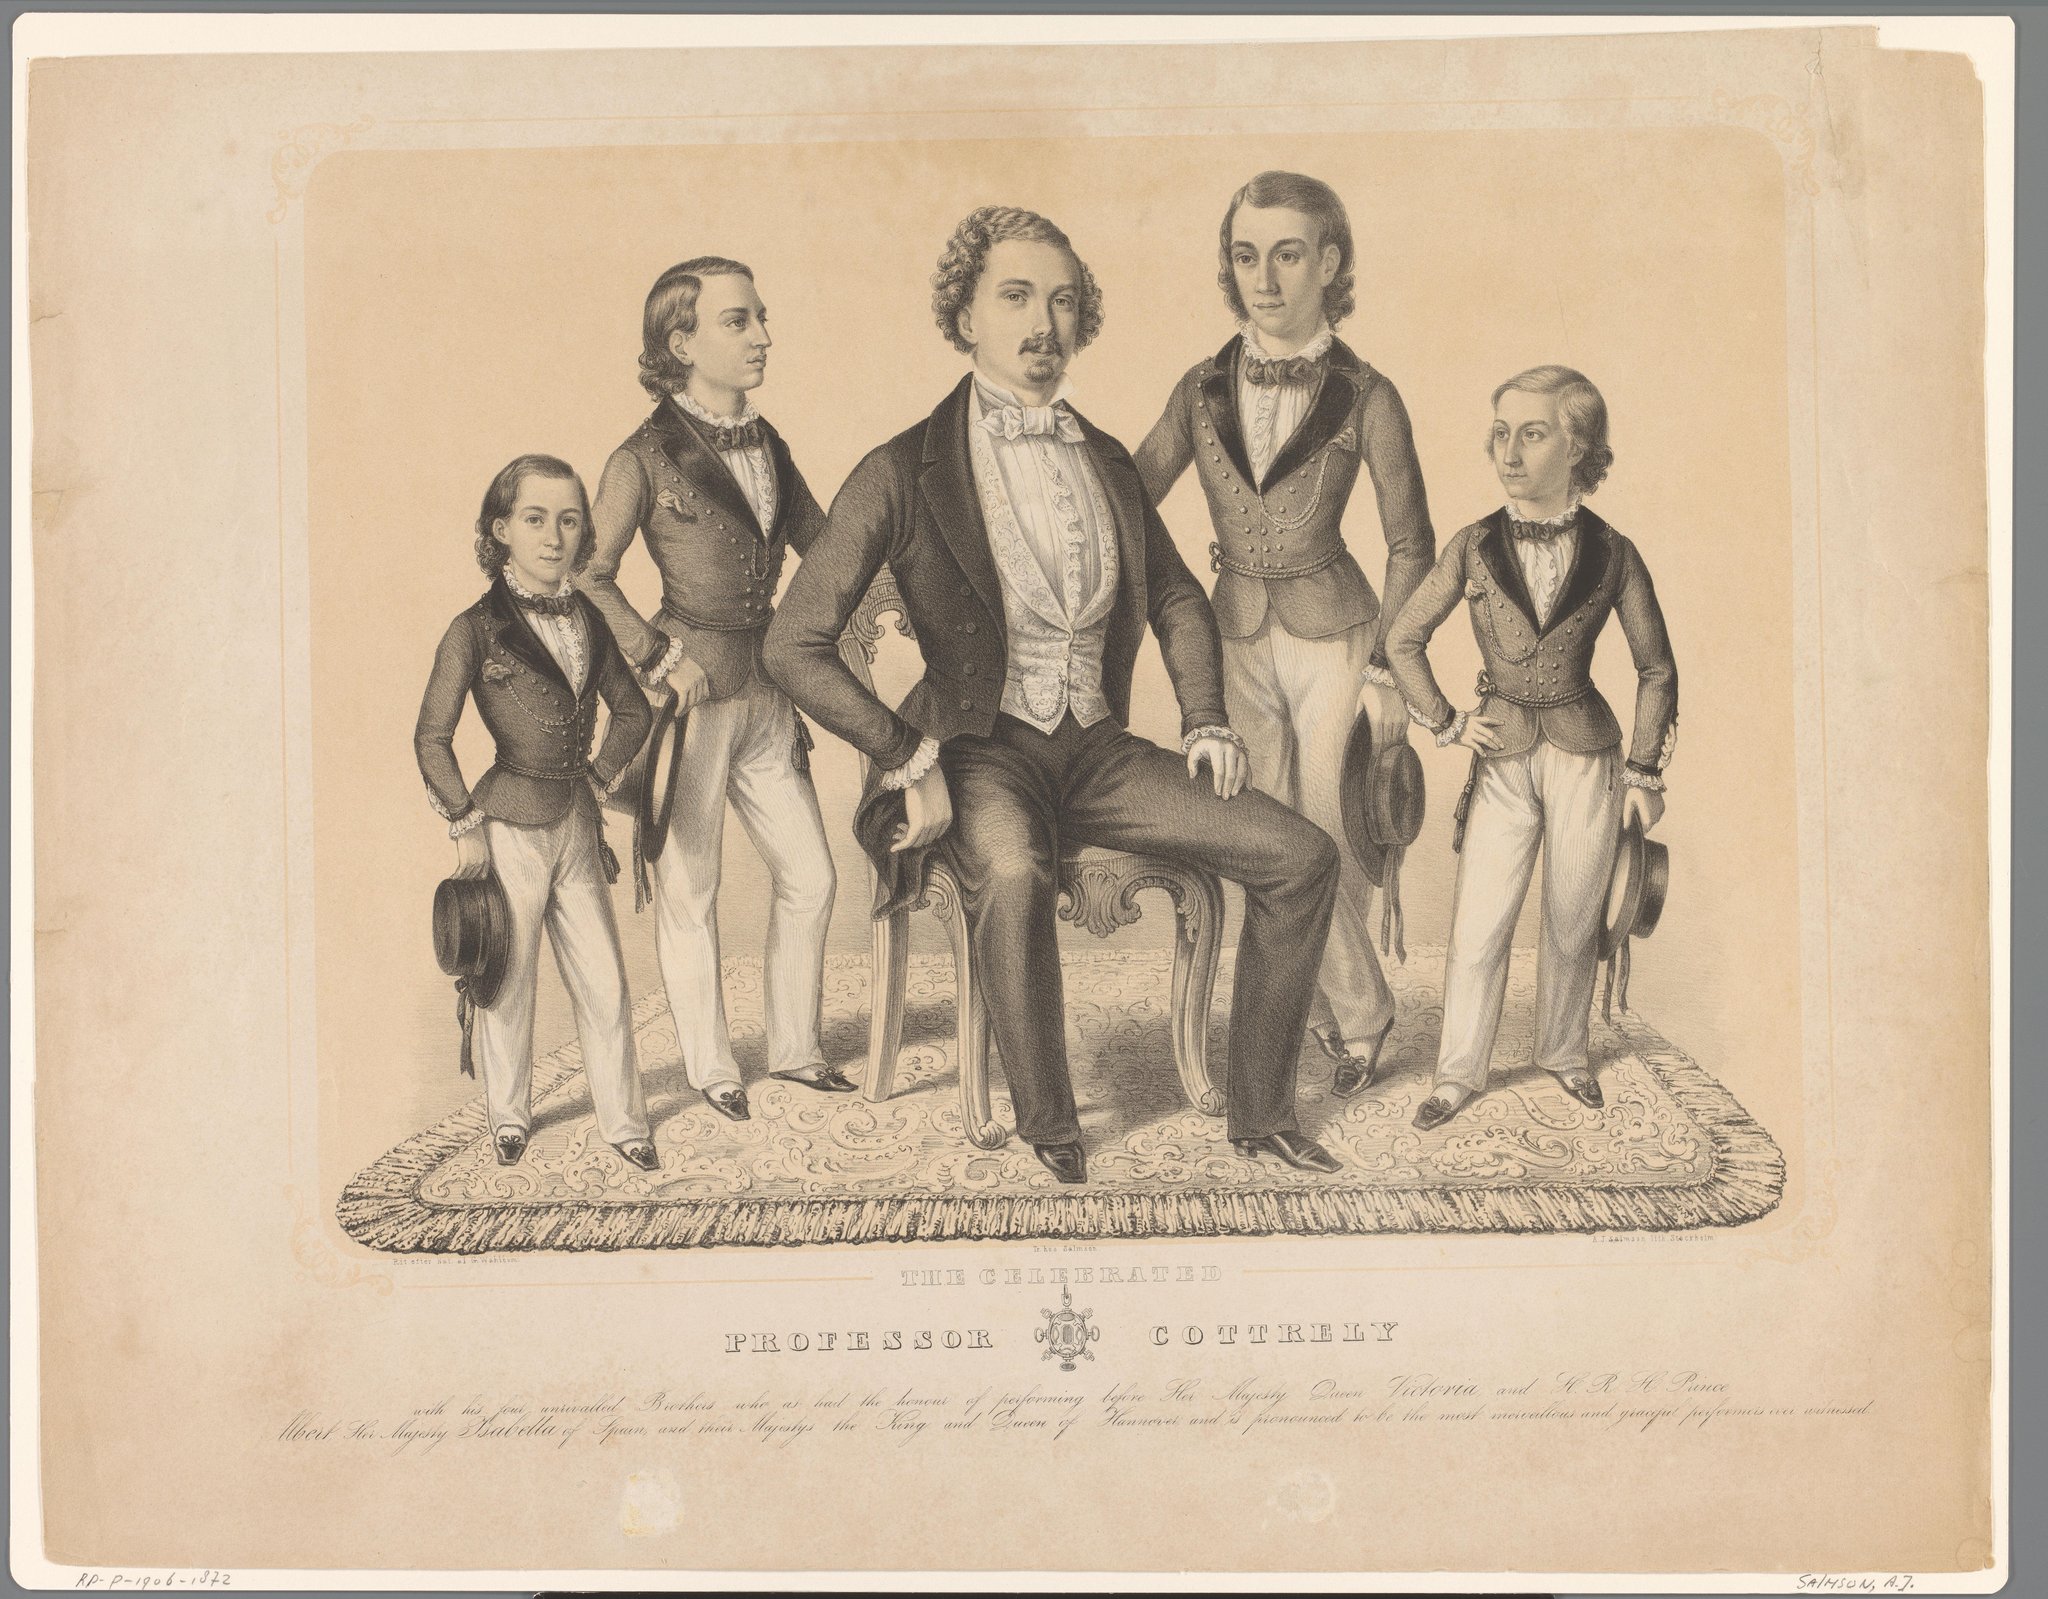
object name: print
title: Portret van Professor Cottrely en zijn vier broers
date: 1848-1862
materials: paper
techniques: lithograph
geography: stockholm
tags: anonymous historical persons portrayed in a group, in a group-portrait - bb - woman, historical persons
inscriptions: signature: ‘A.J. Salmson lith. Stockholm.’, inscription: ‘The celebrated / Professor Cottrely’, collector's mark: Lugt 2228, signature: ‘Tr. hos Salmson.’, signature: ‘Rit. efter Nat. af G.Wahloom.’